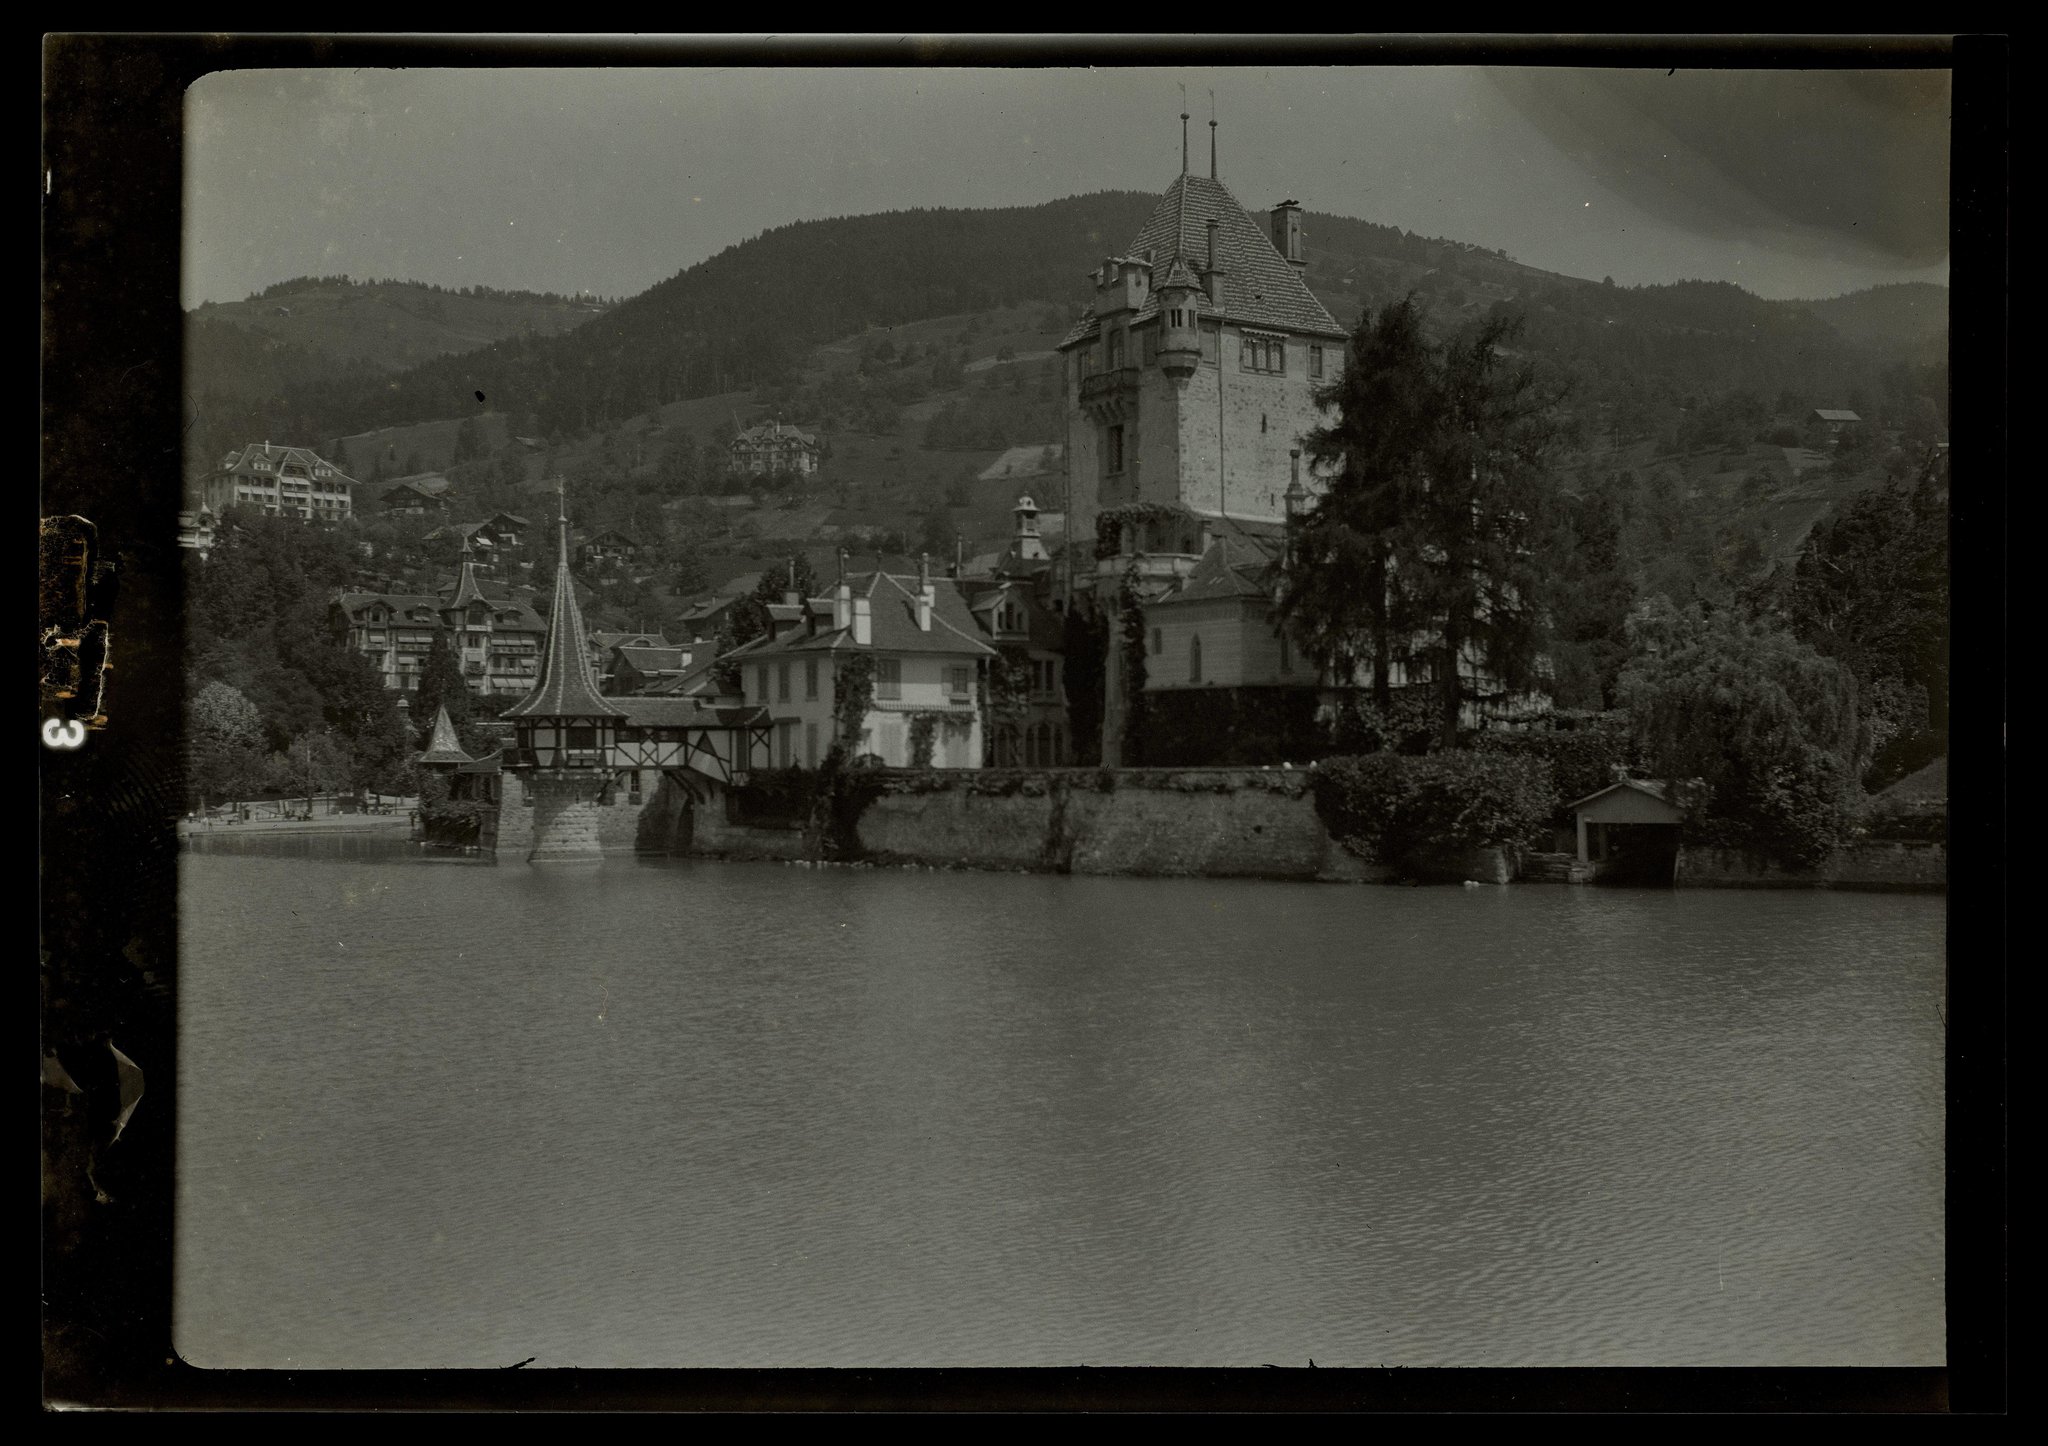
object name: negative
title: Filmnegatief met opname van Basel, Thun, Kandersteg of Gemmi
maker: Anonymous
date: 1921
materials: film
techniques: gelatin silver negative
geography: switzerland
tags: switzerland